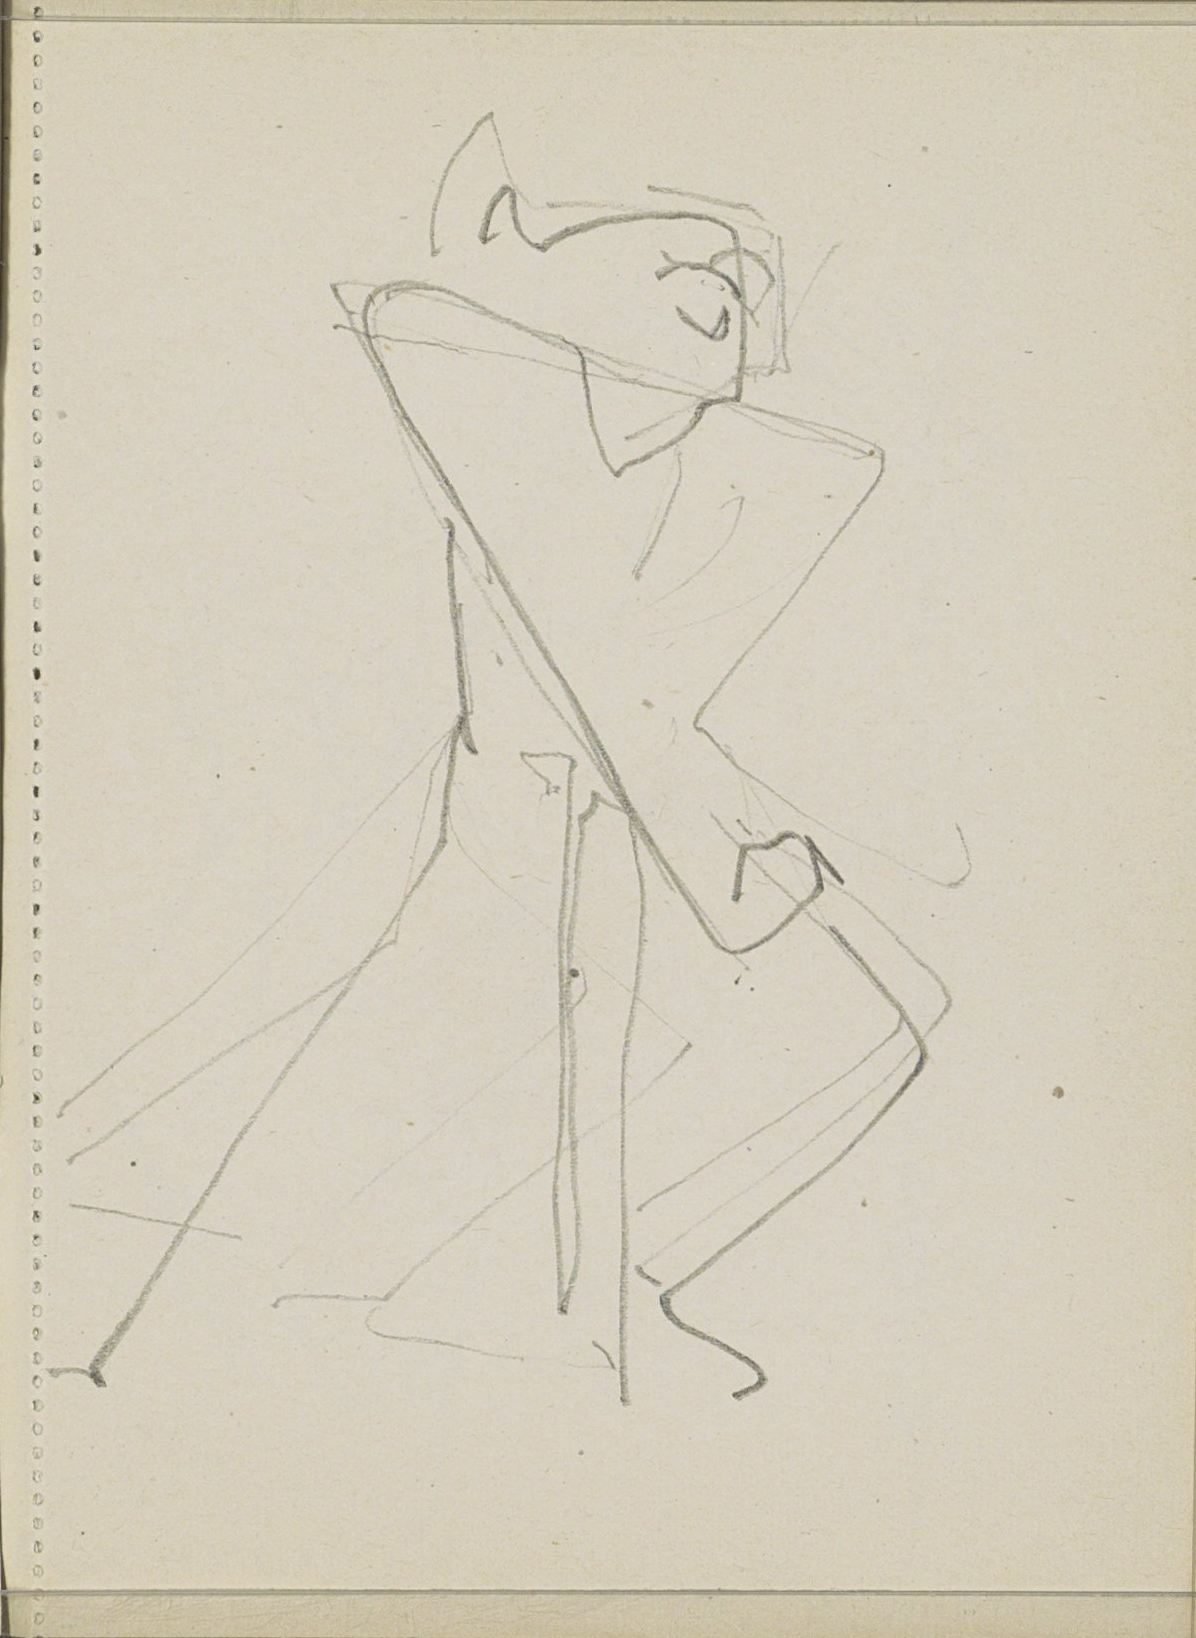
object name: sketchbook leaf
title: Danser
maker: reijer stolk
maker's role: draughtsman, print maker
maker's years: 1896-1945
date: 1906-1945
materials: paper, pencil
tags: one person dancing alone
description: Blad 18 recto uit een schetsboek met 53 bladen.